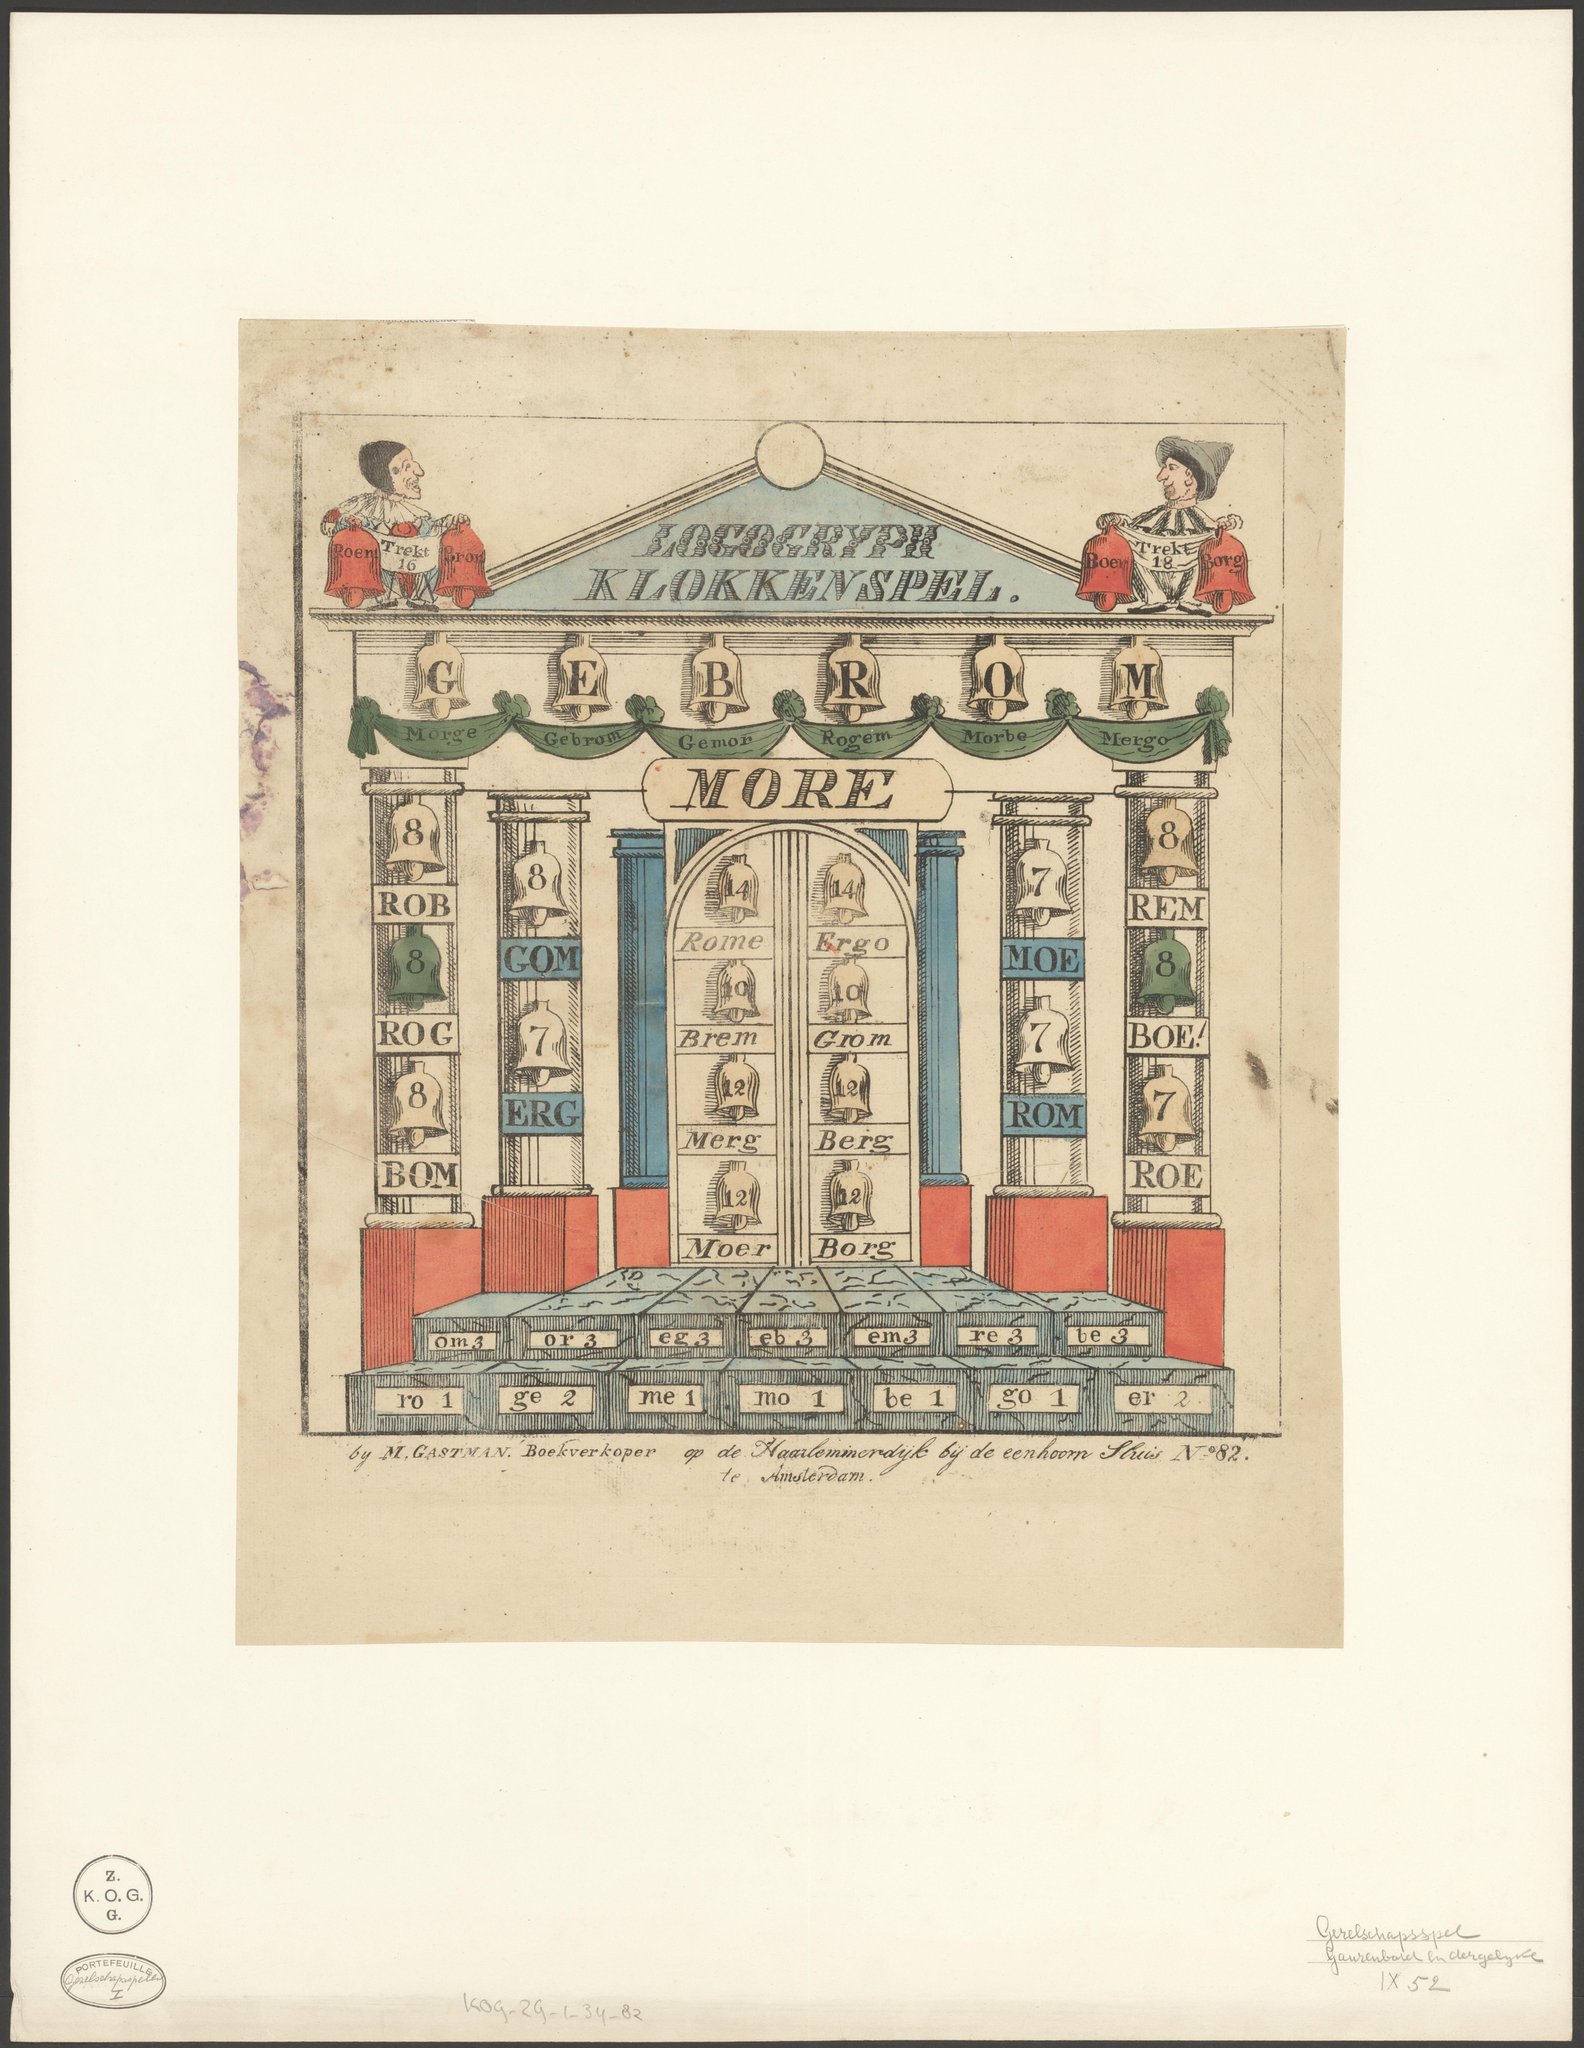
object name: print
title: Logogryph Klokkenspel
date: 1823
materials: paper, watercolor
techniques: etching, hand coloring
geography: netherlands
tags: goose-game, carillon, chimes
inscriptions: collector's mark: Lugt 1641, collector's mark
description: Een gezelschapsspel in de vorm van een gebouw. Aan de kroonlijst hangen 6 klokken waarin letters samen het woord 'gebrom' vormen. Op de zuilen en de deur hangen klokken met de cijfers 7, 8, 10, 12 en 14 waaronder steeds enkele letters die in het woord 'gebrom' voorkomen. Boven de deur in grote letters het woord 'more'. Op de stoep 14 tegels met de cijfers 1, 2 en 3 en steeds 2 letters die voorkomen in het woord 'gebrom'. Onderwerpsrubrieken binnen de Atlas Zeden en Gewoonten: Spel en Vermaak; gezelschapsspel, ganzenbord en dergelijke.